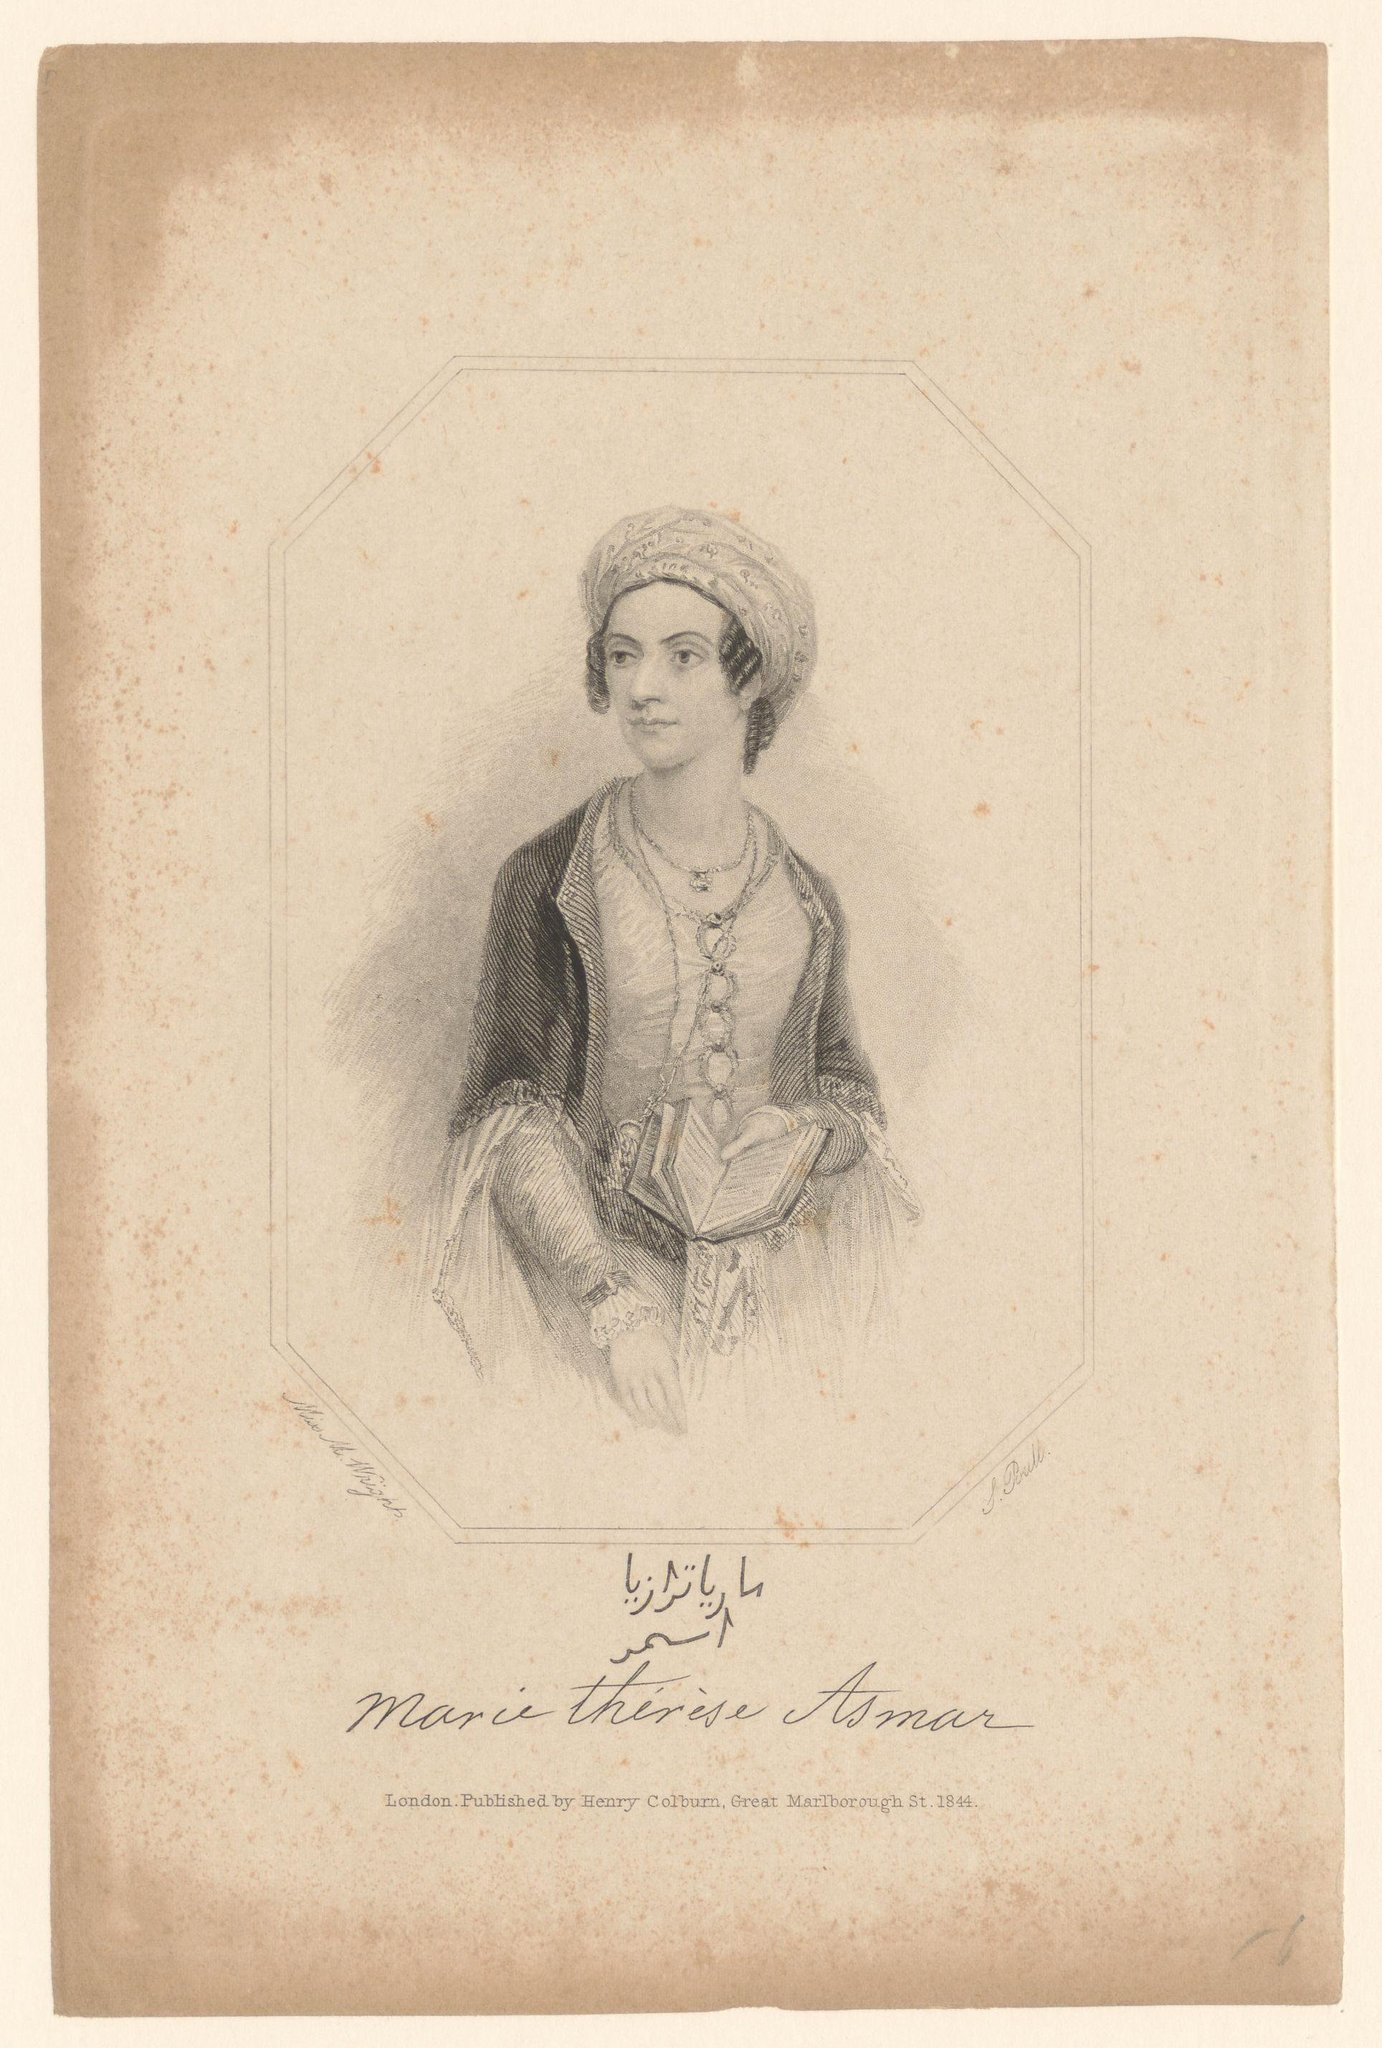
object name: book illustration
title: Marie Thérèse Asmar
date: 1844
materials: paper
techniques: engraving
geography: london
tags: traveler, historical persons, portrait of a writer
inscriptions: collector's mark: Lugt 2228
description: Prent uit: Asmar, Maria Theresa. Memoirs of a Babylonian Princess. Londen: Henry Colburn, 1844, dl. 1.